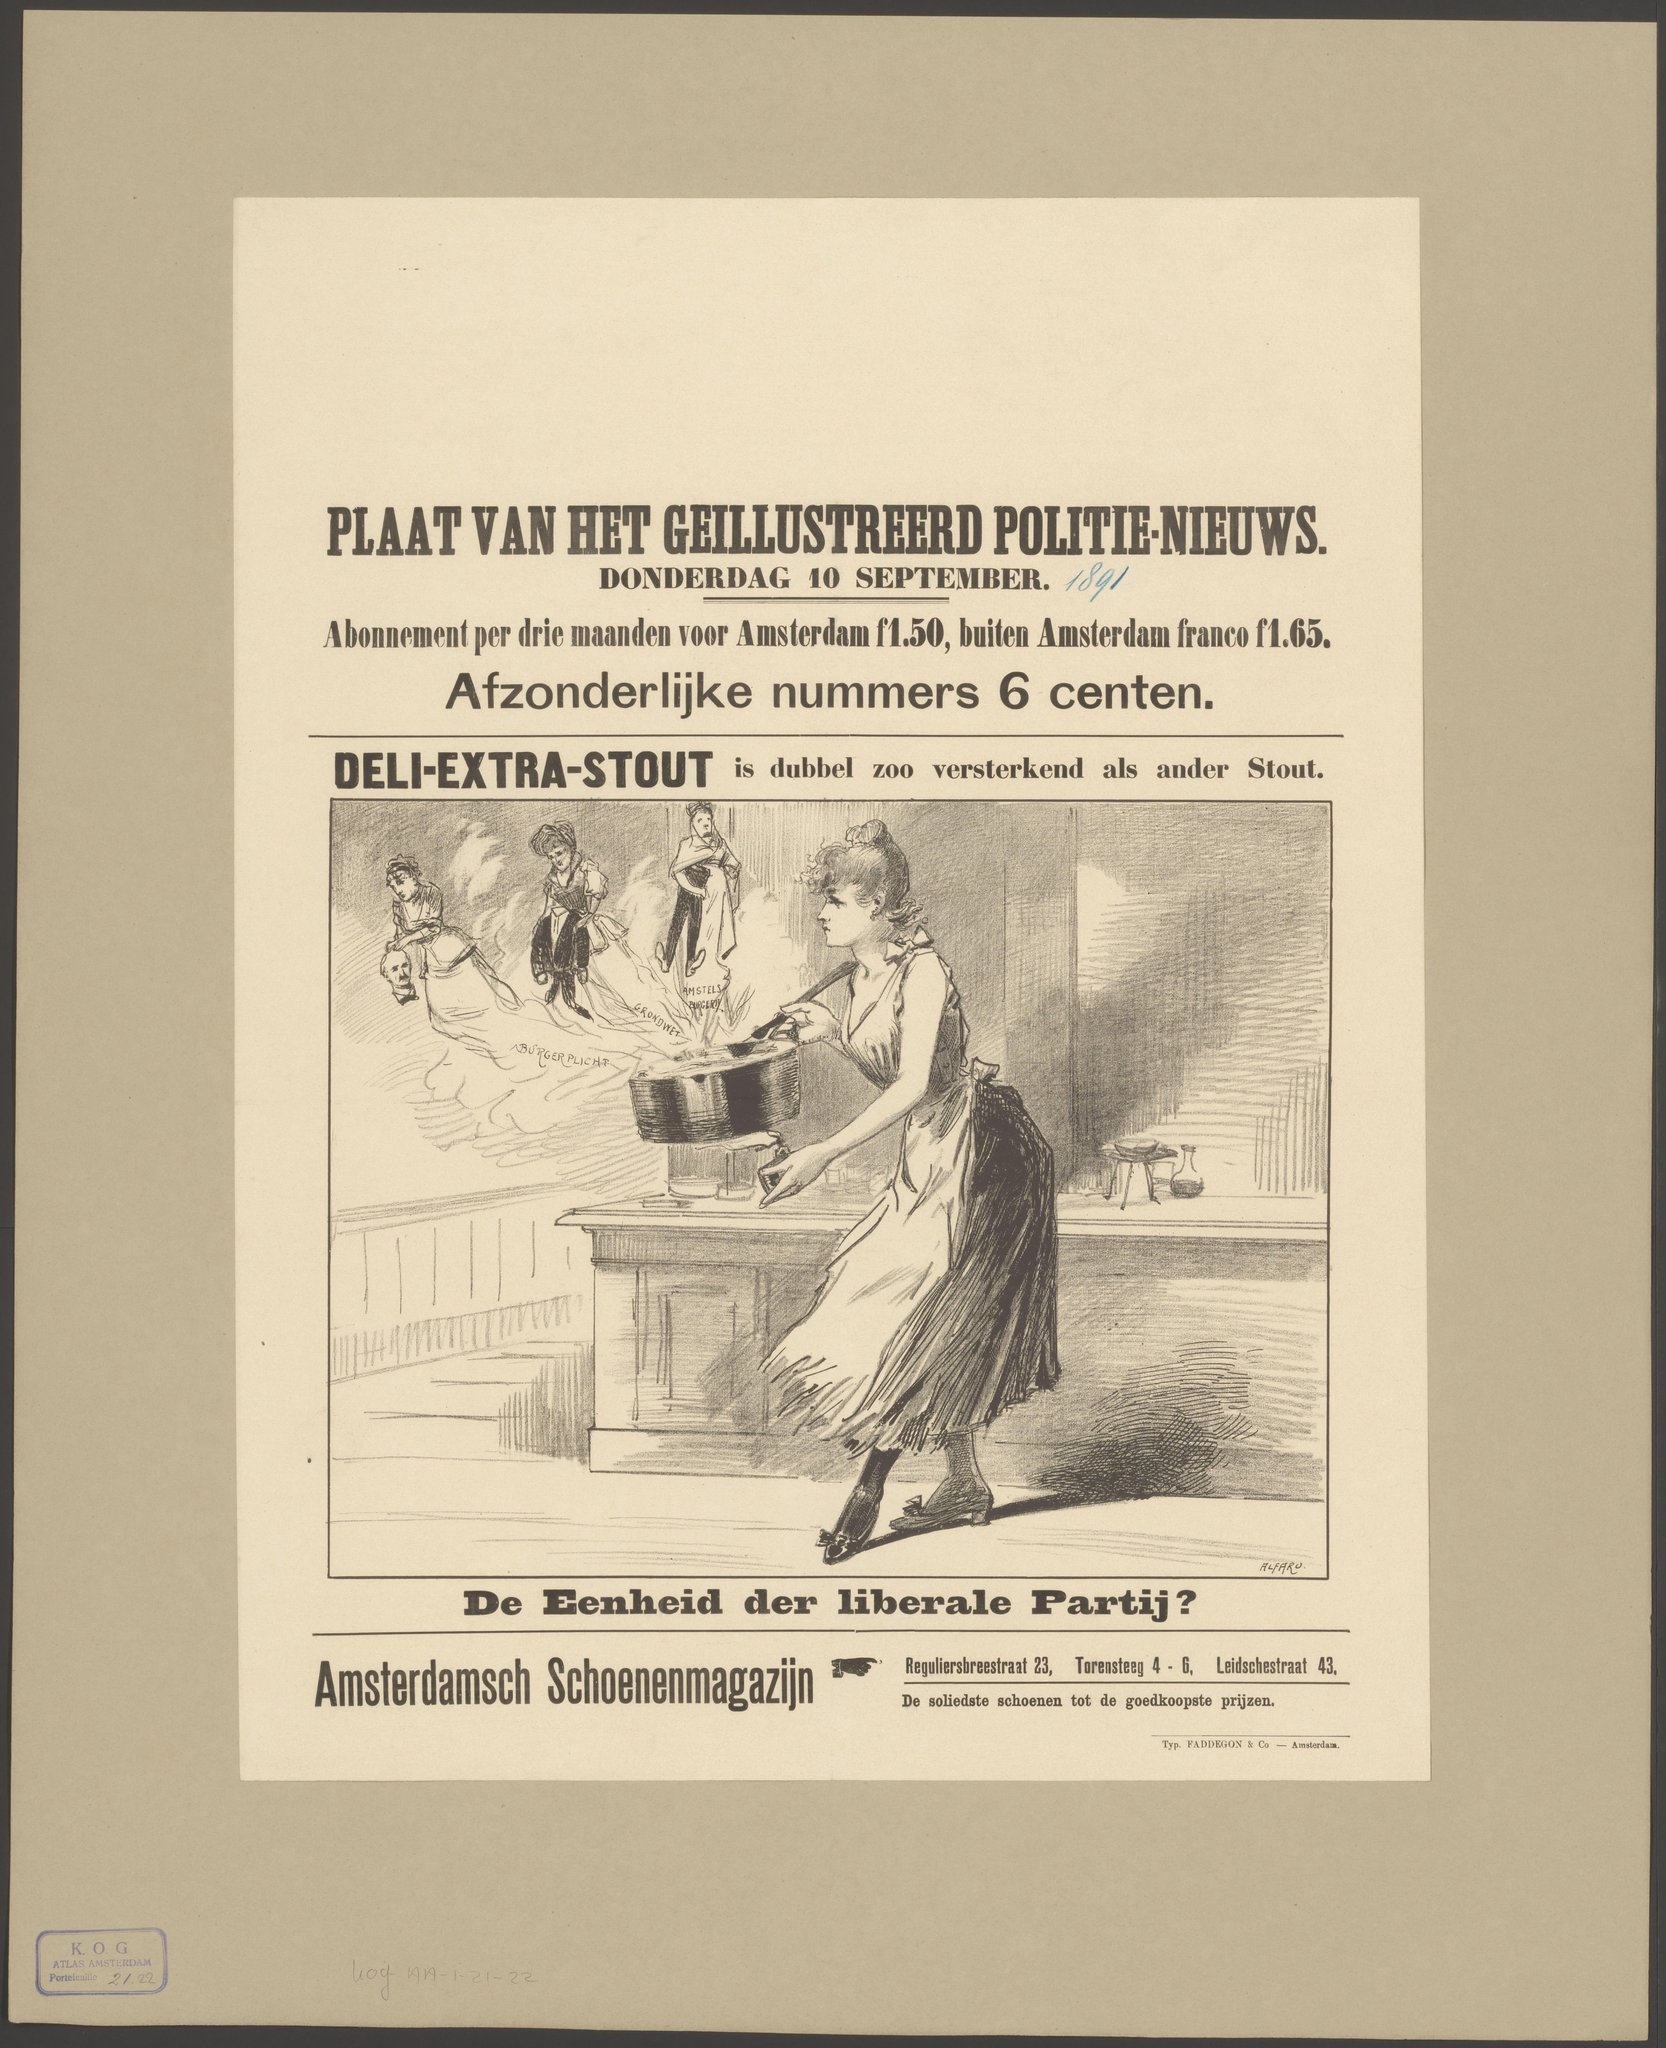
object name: cartoon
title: De Eenheid der liberale Partij?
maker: alfaro reijding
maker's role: draughtsman, engineer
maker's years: 1863-1930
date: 1891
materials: paper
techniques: letterpress printing, lithograph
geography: amsterdam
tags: kitchen-utensils: pan, political caricatures and satires, amsterdam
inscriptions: collector's mark: Lugt 1641b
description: Gepubliceerd als bijvoegsel van 'Geïllustreerd Politie-Nieuws', 10 september 1891.